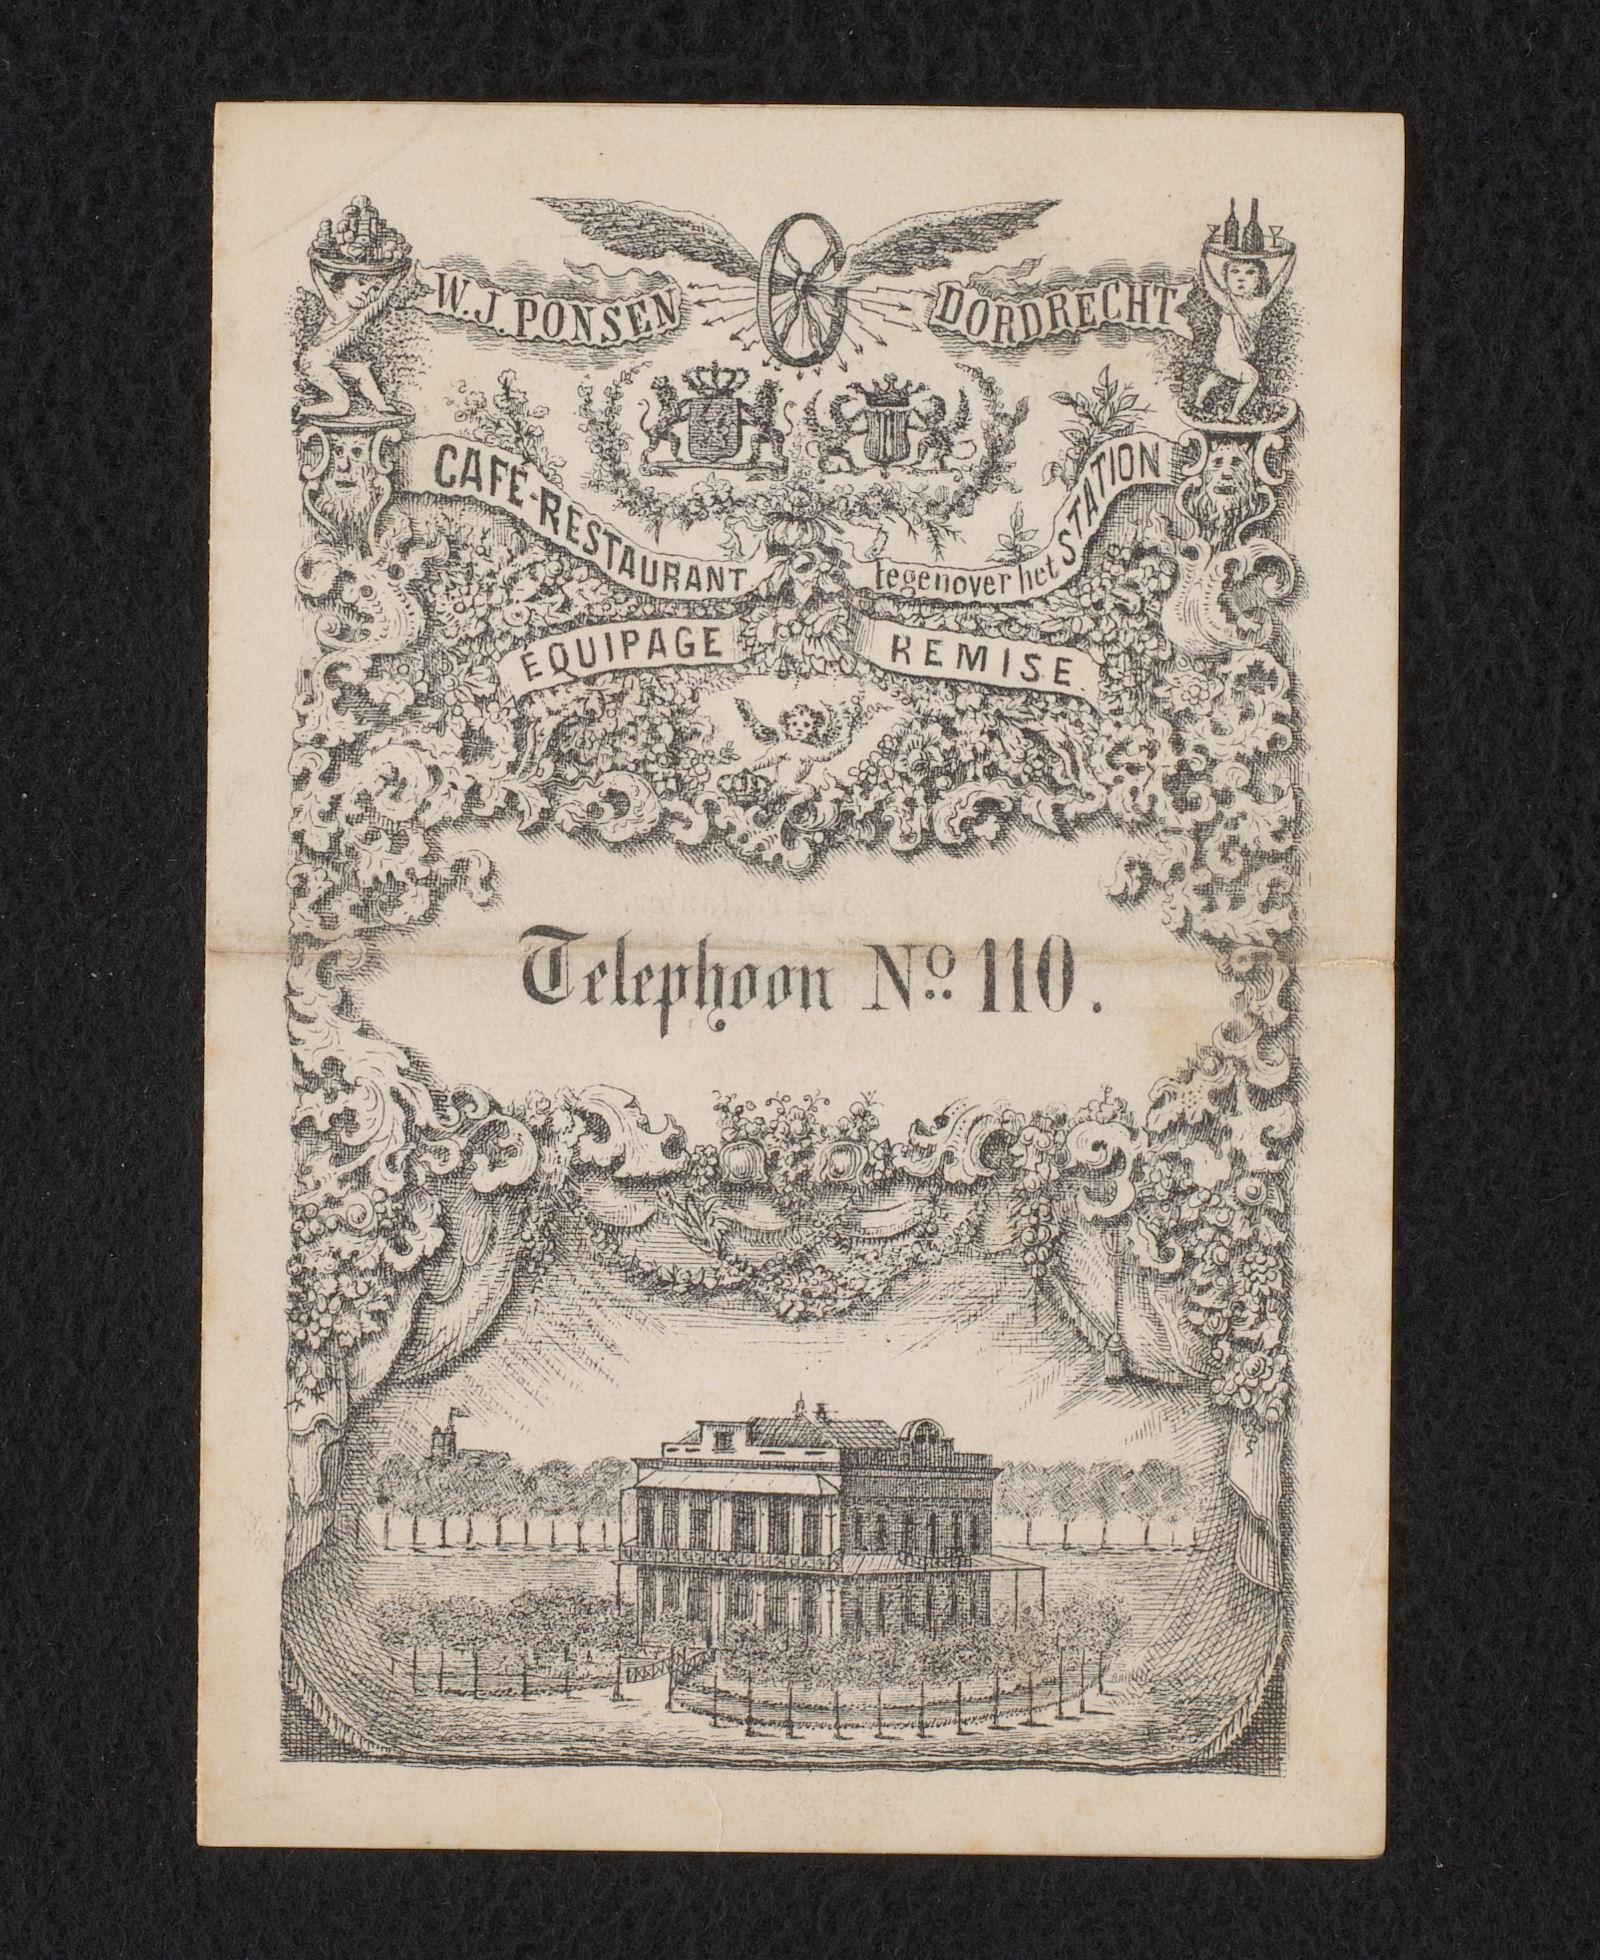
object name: photomechanical print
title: Menukaart voor de feestmaaltijd ter gelegenheid van de '35e Algemeene Vergadering der Nederlandsche Maatschappij ter Bevordering der Pharmacie'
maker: Anonymous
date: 1886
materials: paper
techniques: printing block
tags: city-view in general; 'veduta', maps of cities, dordrecht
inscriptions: collector's mark: ‘Emile Steijns apotheker Helmond’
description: Uitnodiging en menukaart voor een feestmaaltijd in cafe-restaurant équipage-remise W.J. Ponsen te Dordrecht, op 9 juni 1886. Op de voorzijde een gezicht op het restaurant in een decoratief kader met bovenin tevens een gevleugeld wiel (verwijzing naar de locatie van het restaurant vlakbij station Dordrecht). Binnenin het menu en de wijnlijst, en op de achterzijde een plattegrond van Dordrecht met de locatie van het restaurant.